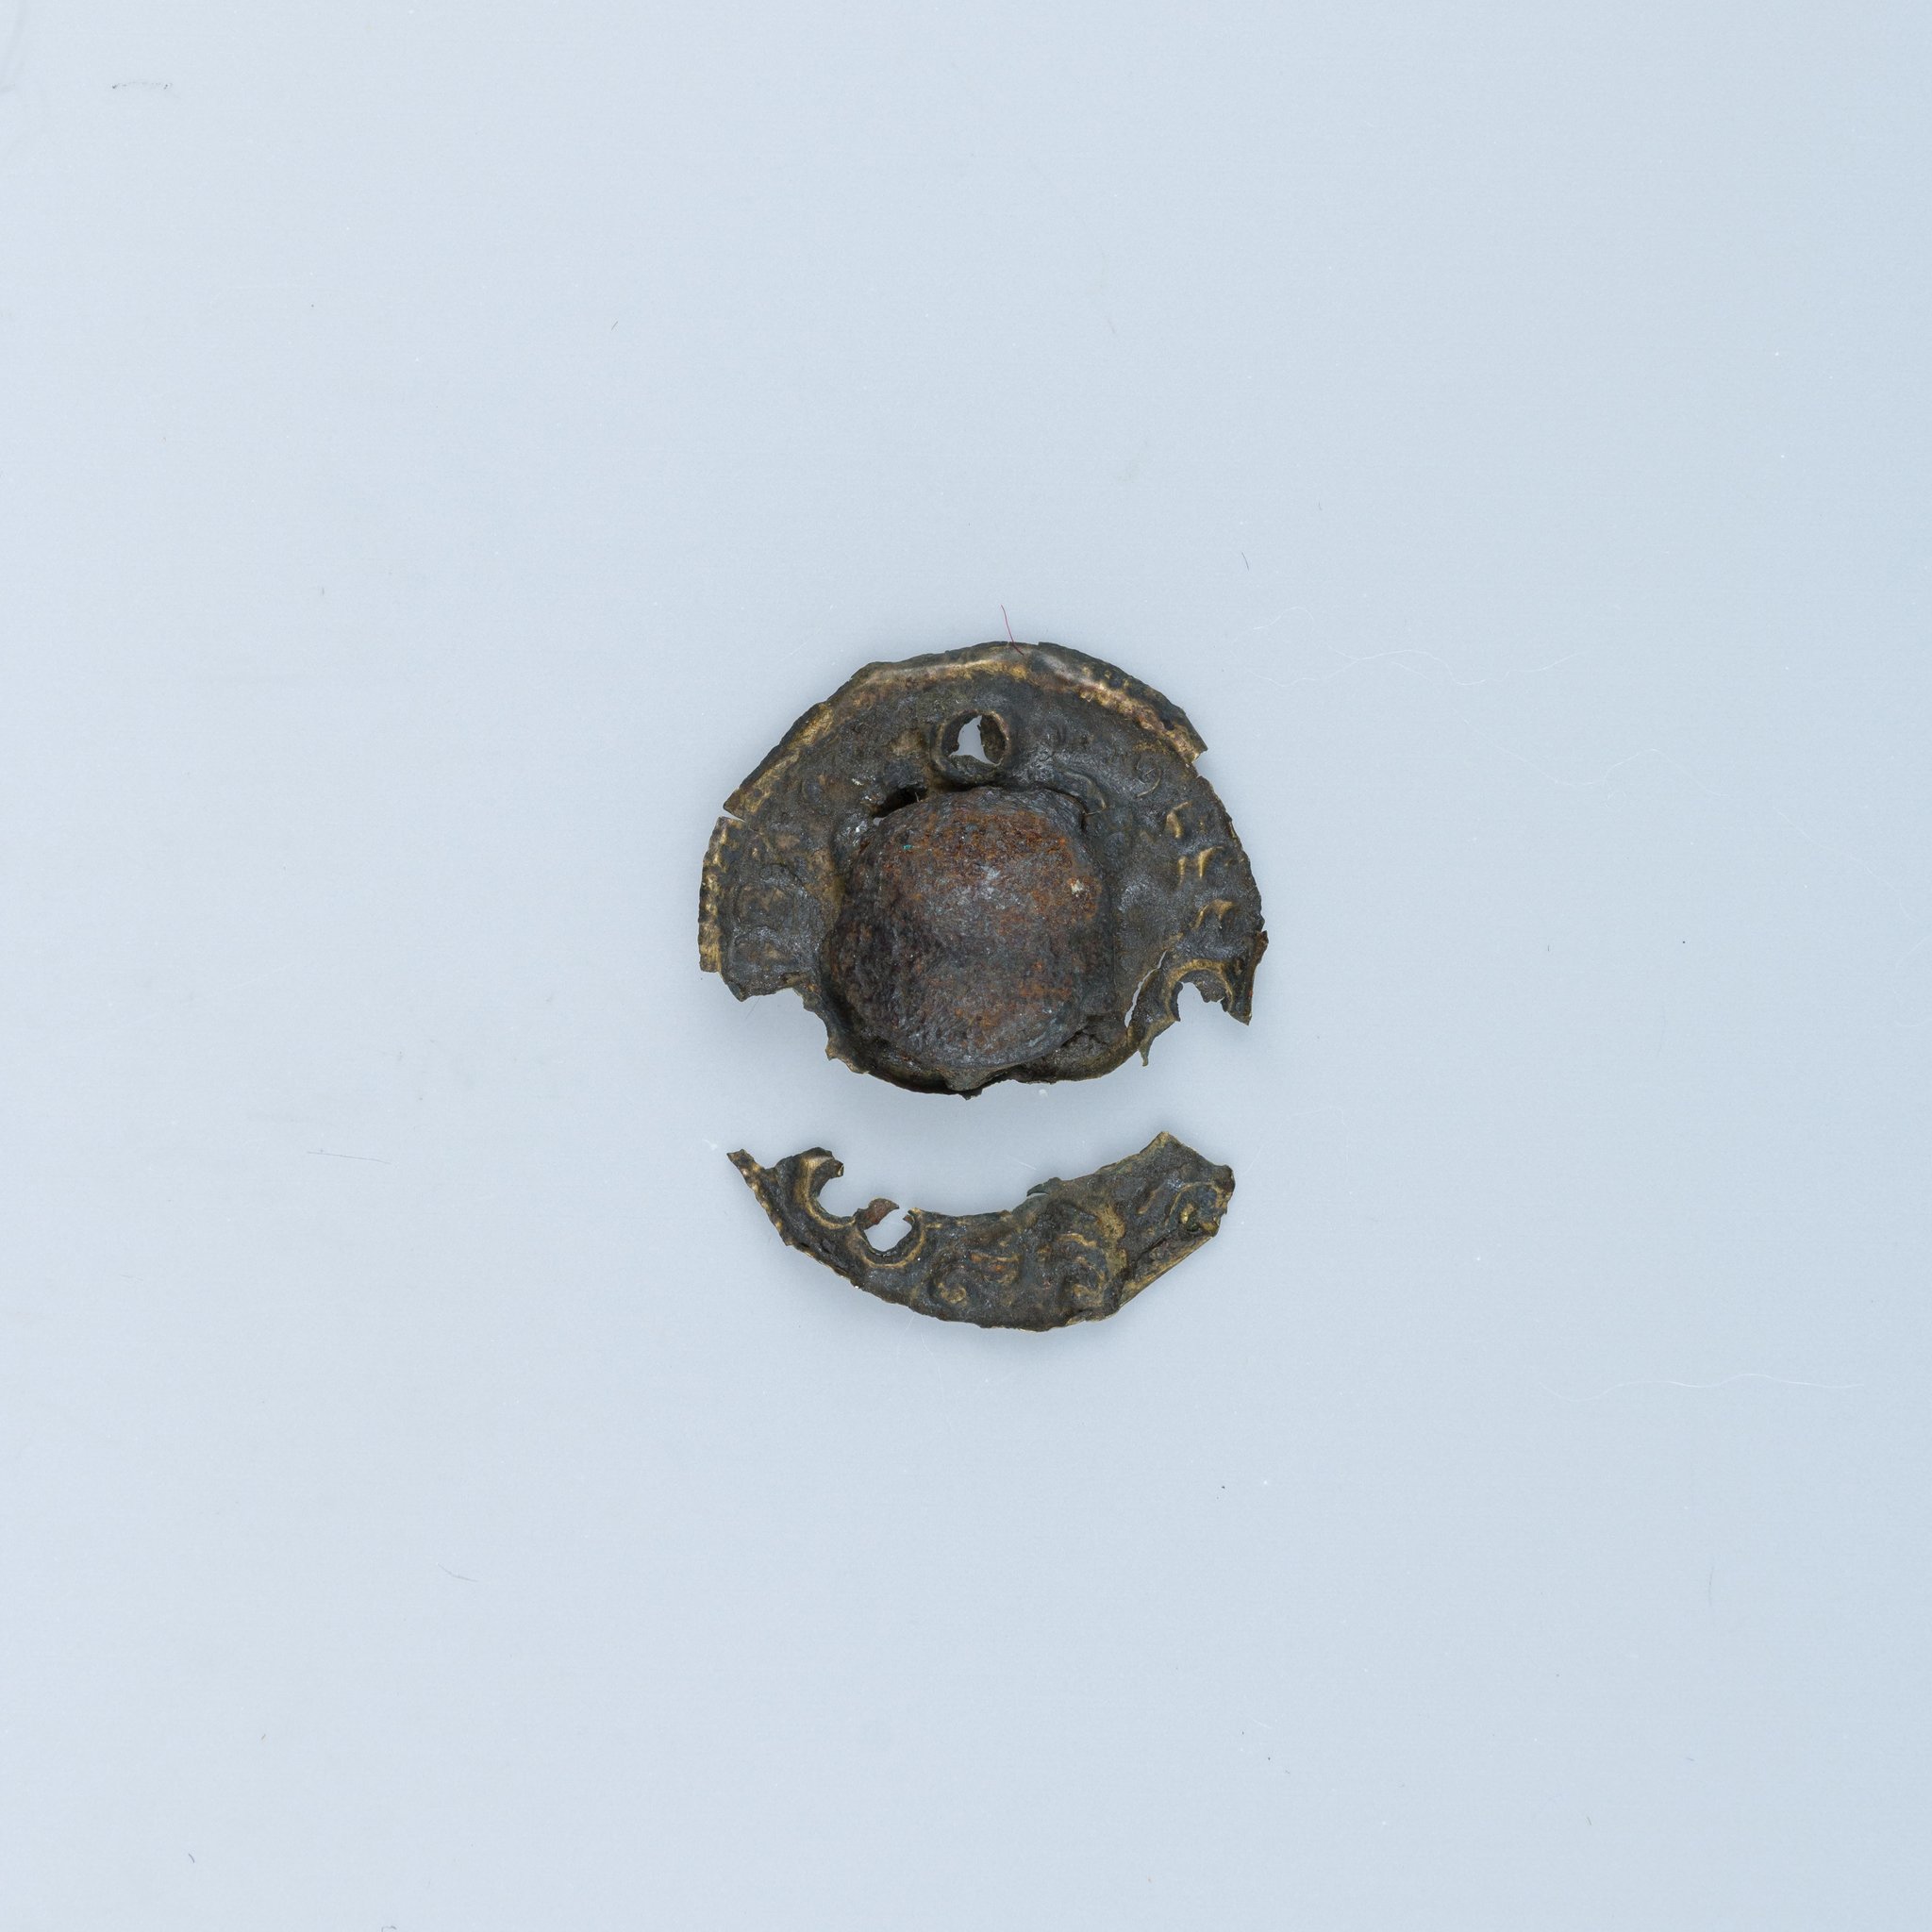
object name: rosette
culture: italian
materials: brass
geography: italy